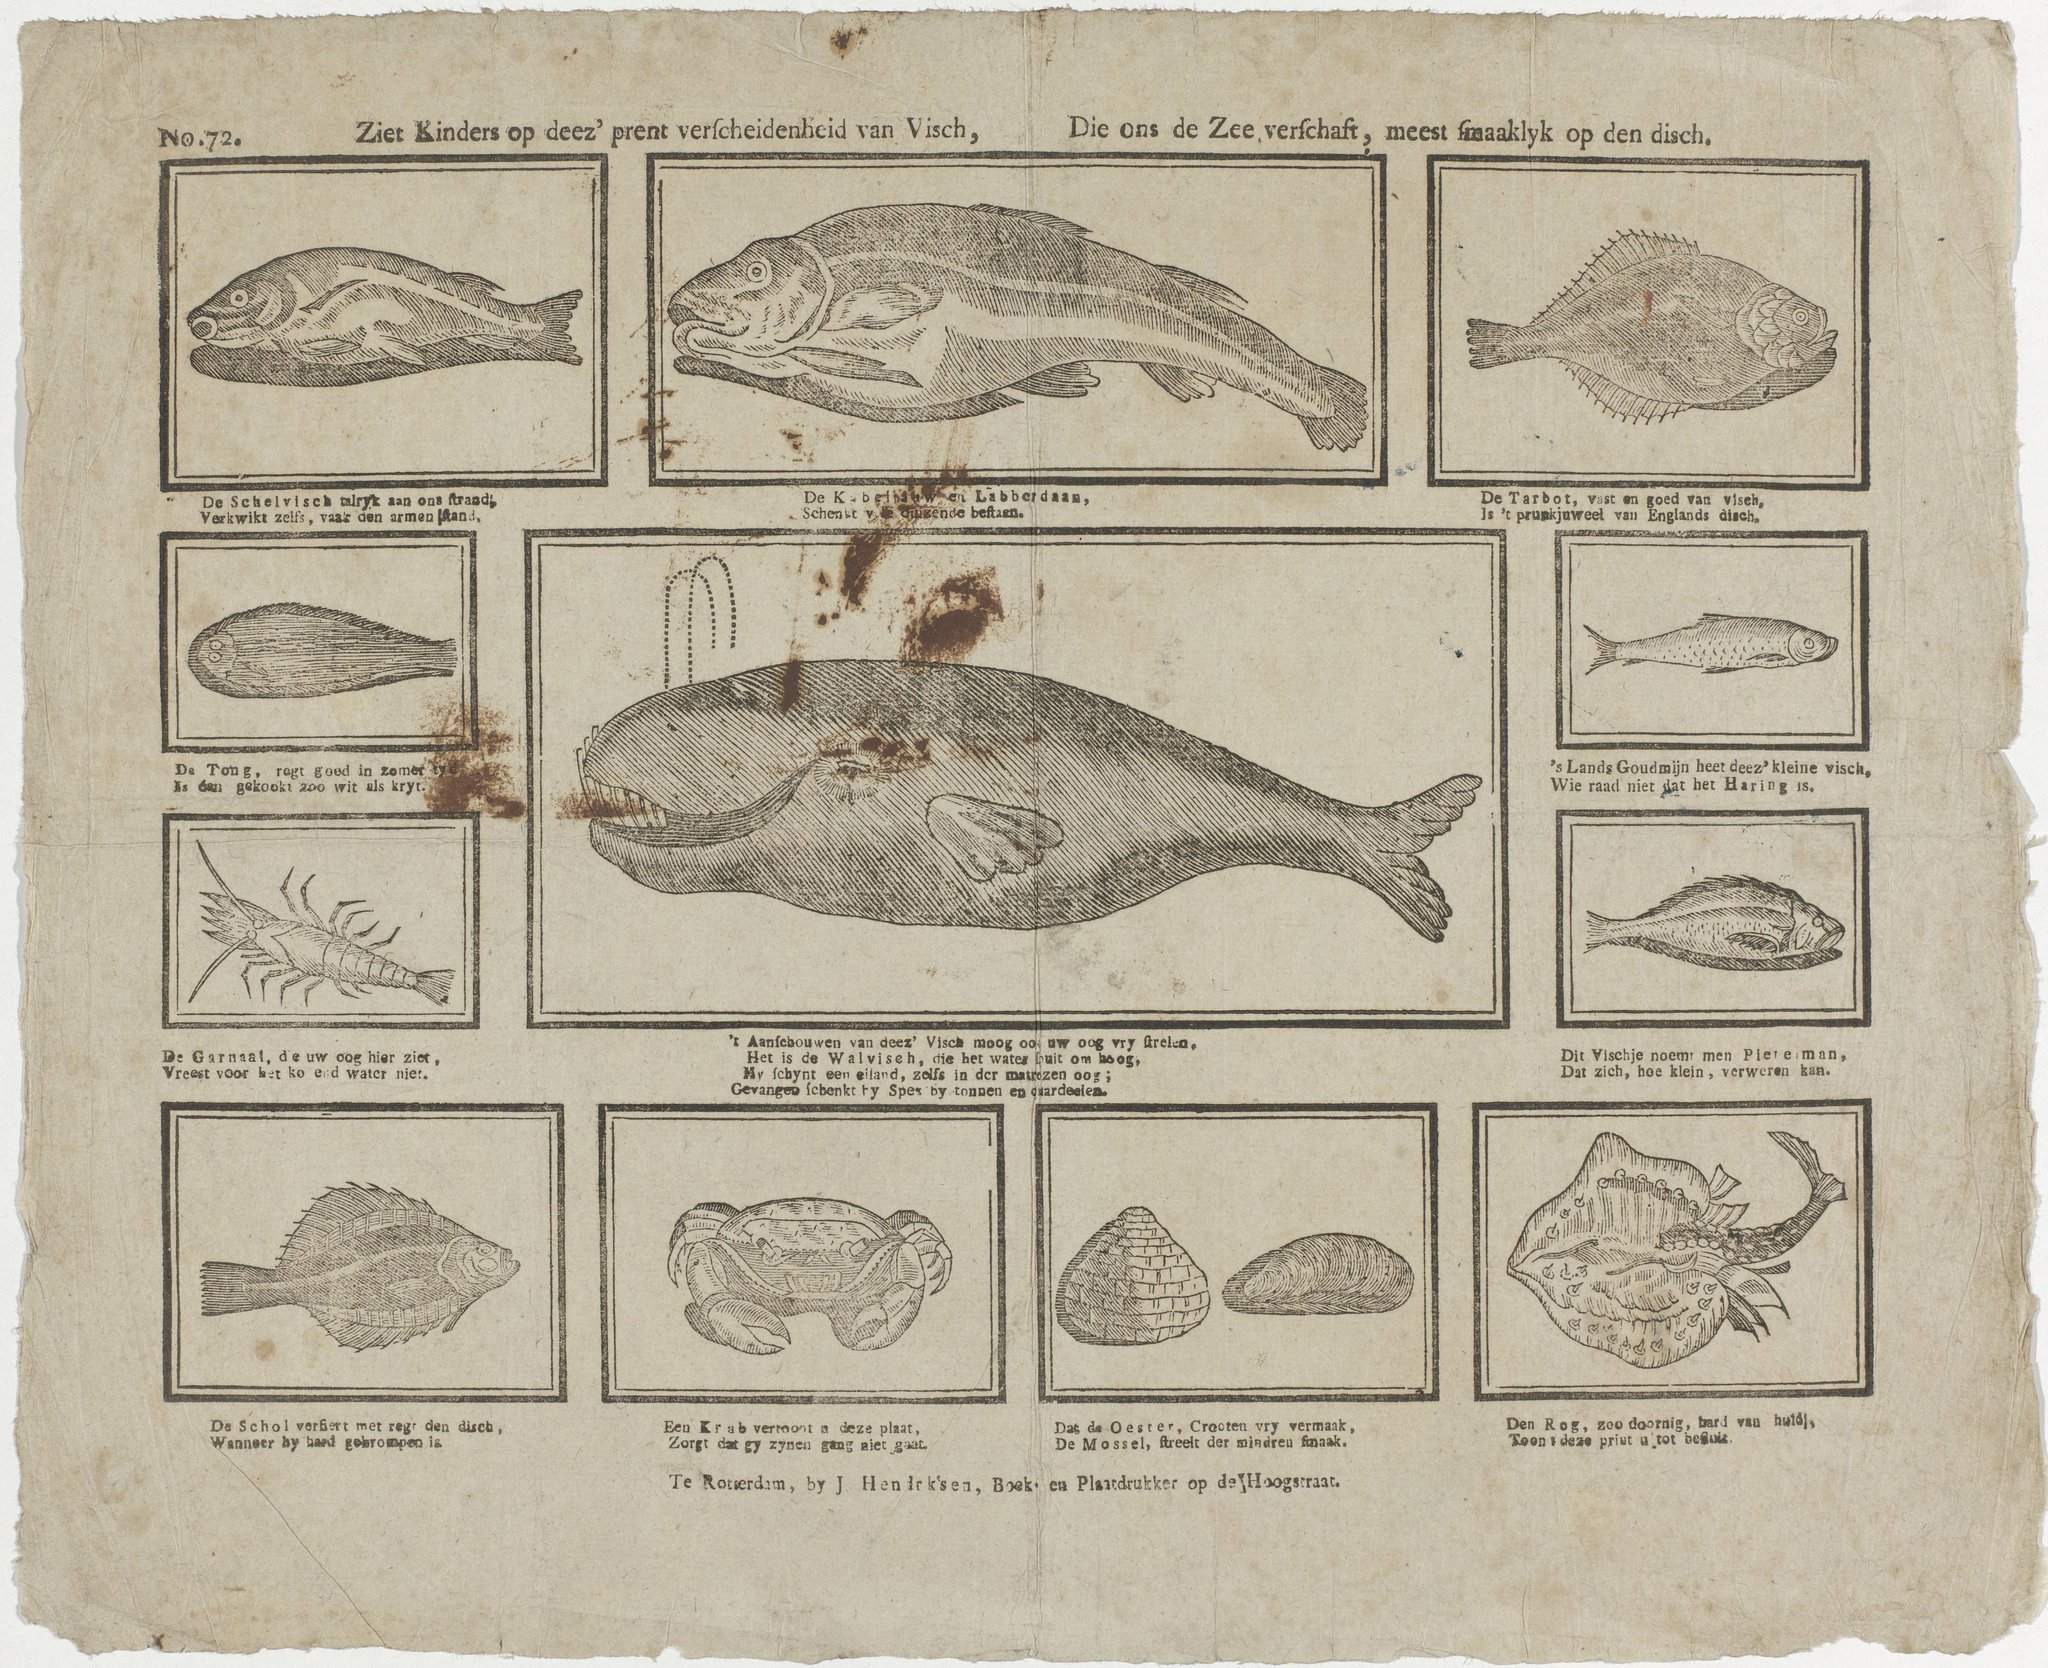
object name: print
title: Ziet kinders op deez' prent verscheidenheid van visch, Die ons de zee verschaft, meest smaaklyk op den disch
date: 1781-1828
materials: paper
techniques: letterpress printing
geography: rotterdam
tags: fishes, crustaceans: crab, cartilaginous fishes: ray, swimming mammals: whale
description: Blad met 12 voorstellingen van dieren uit de zee, zoals een walvis, een krab en een rog. Onder elke afbeelding een twee- of vierregelig vers. Genummerd linksboven: No. 72.